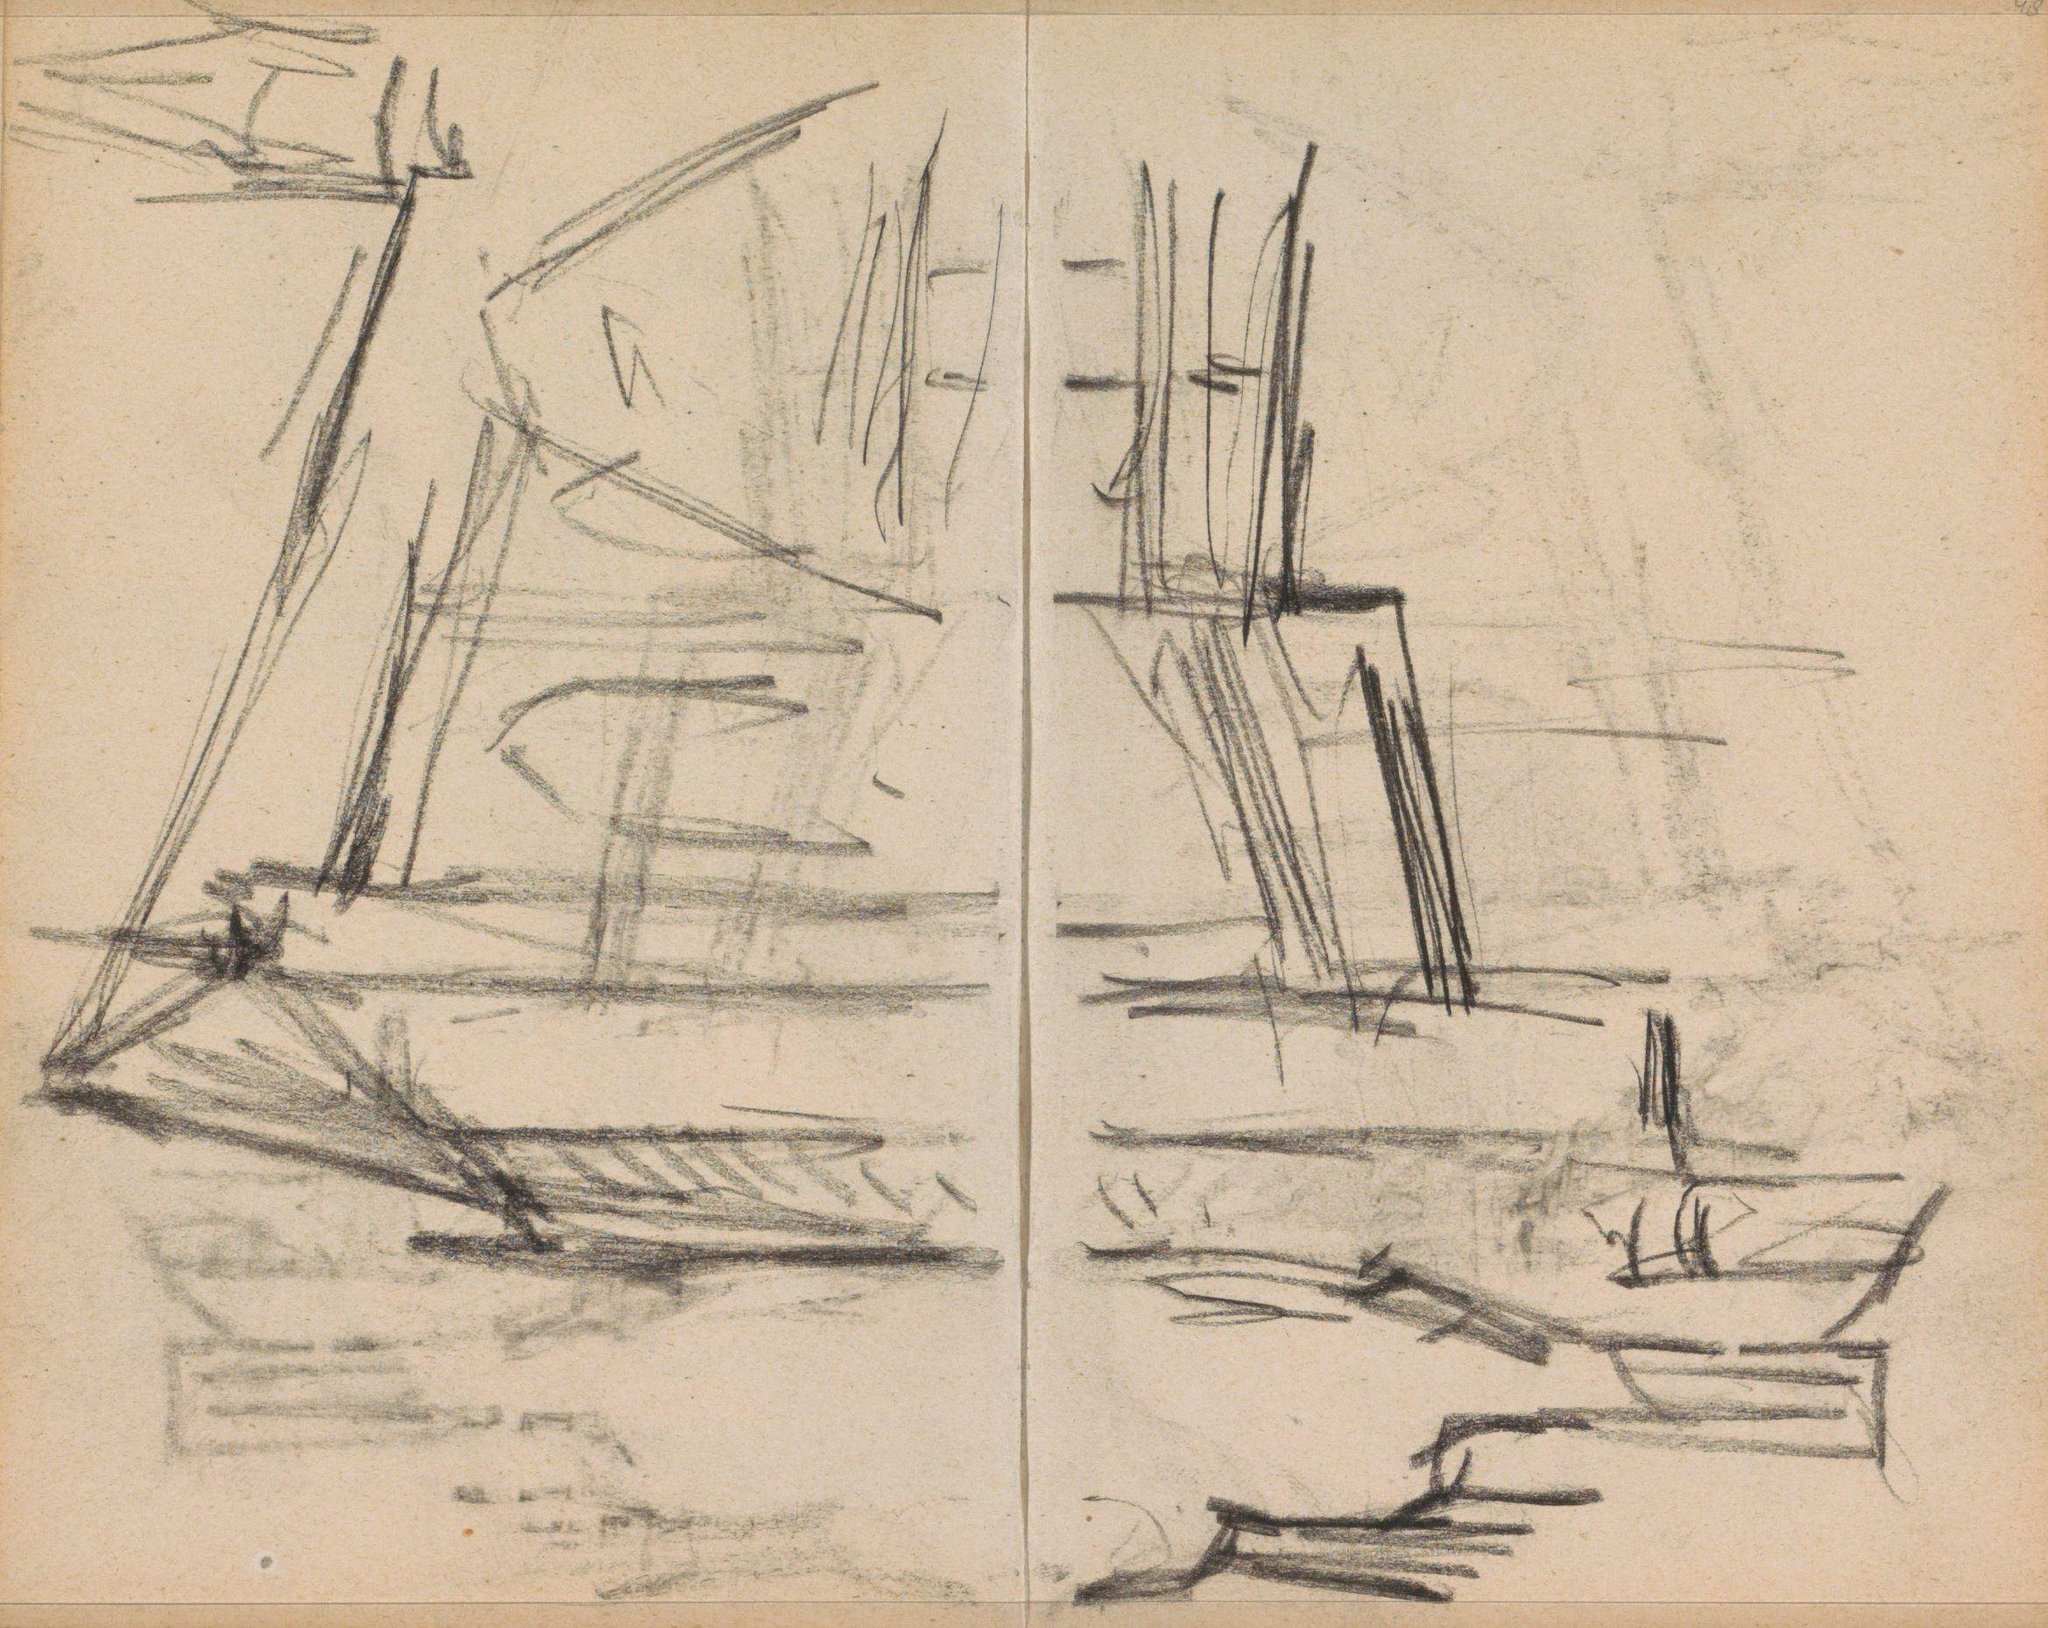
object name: sketchbook leaf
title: Gezicht op de Nieuwe Kerk te Amsterdam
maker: george hendrik breitner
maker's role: draughtsman, painter, print maker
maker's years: 1857-1923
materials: chalk, paper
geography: amsterdam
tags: church (exterior)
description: Pagina 47 en pagina 48 uit een schetsboek met 46 bladen.